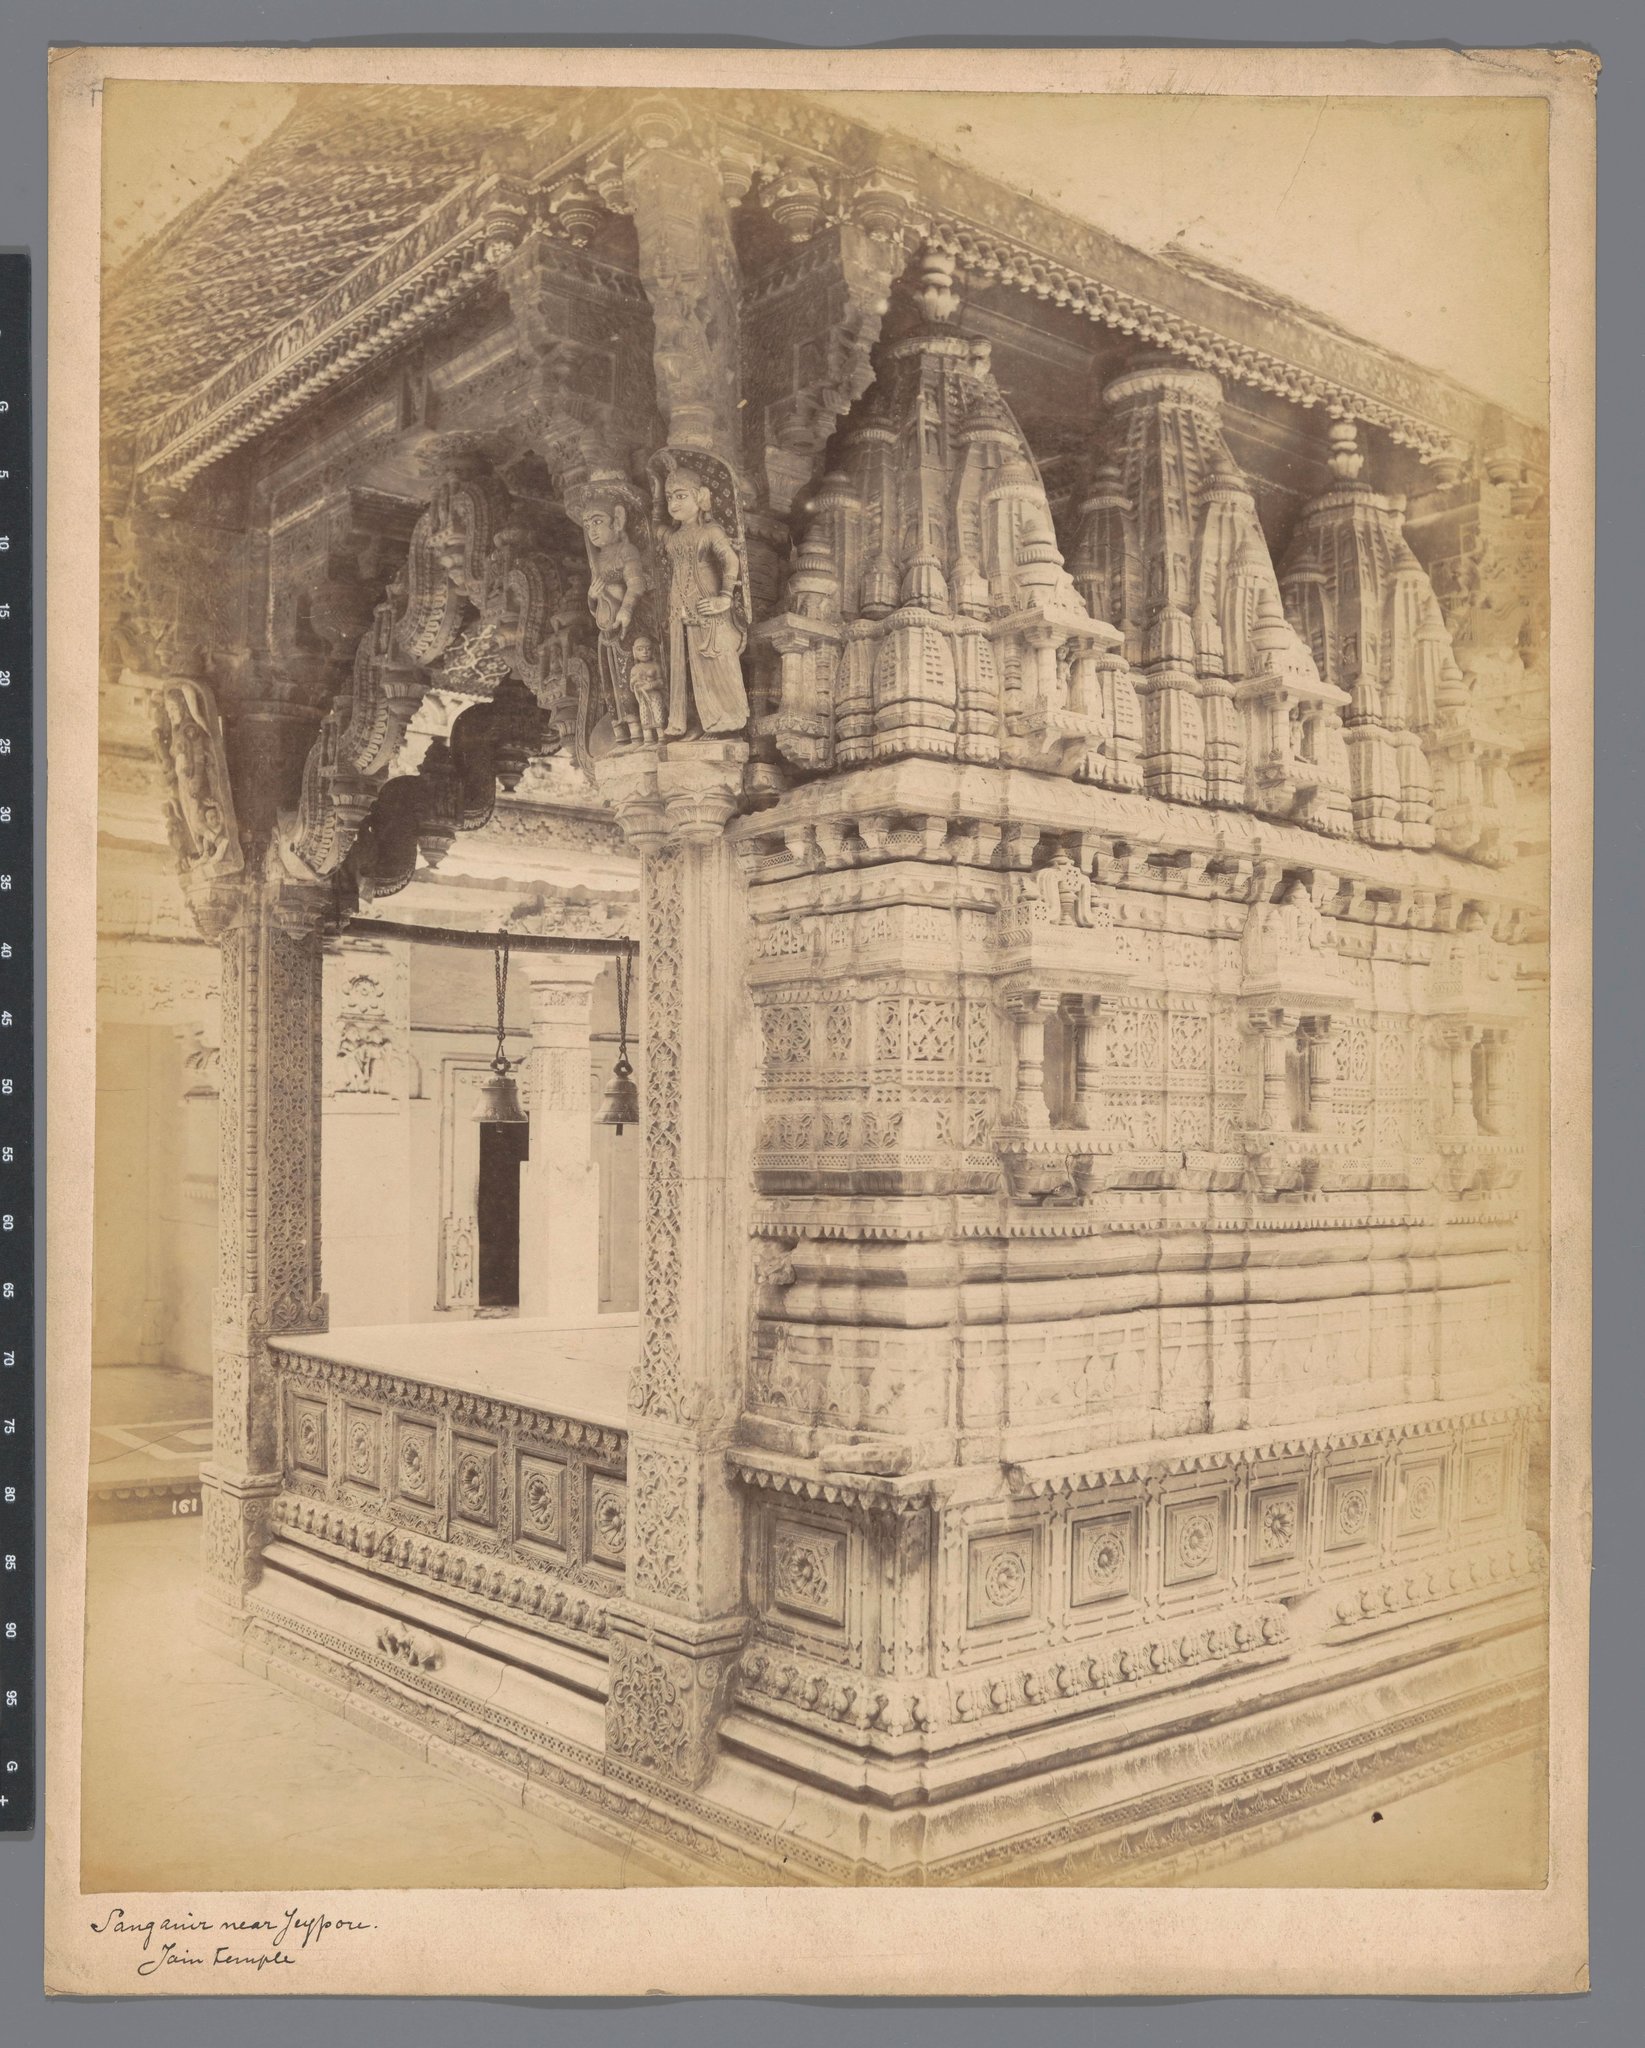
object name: photograph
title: Altar in the Digambar Jain temple in Sanganer near Jaipur, Rajasthan, India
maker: Anonymous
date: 1865-1890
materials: cardboard, paper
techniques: albumen print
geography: sanganer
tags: altar ~ non-christian religions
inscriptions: title: ‘Sanganir near Jeypore./ Jain Temple’, number: ‘161’, number: ‘94’